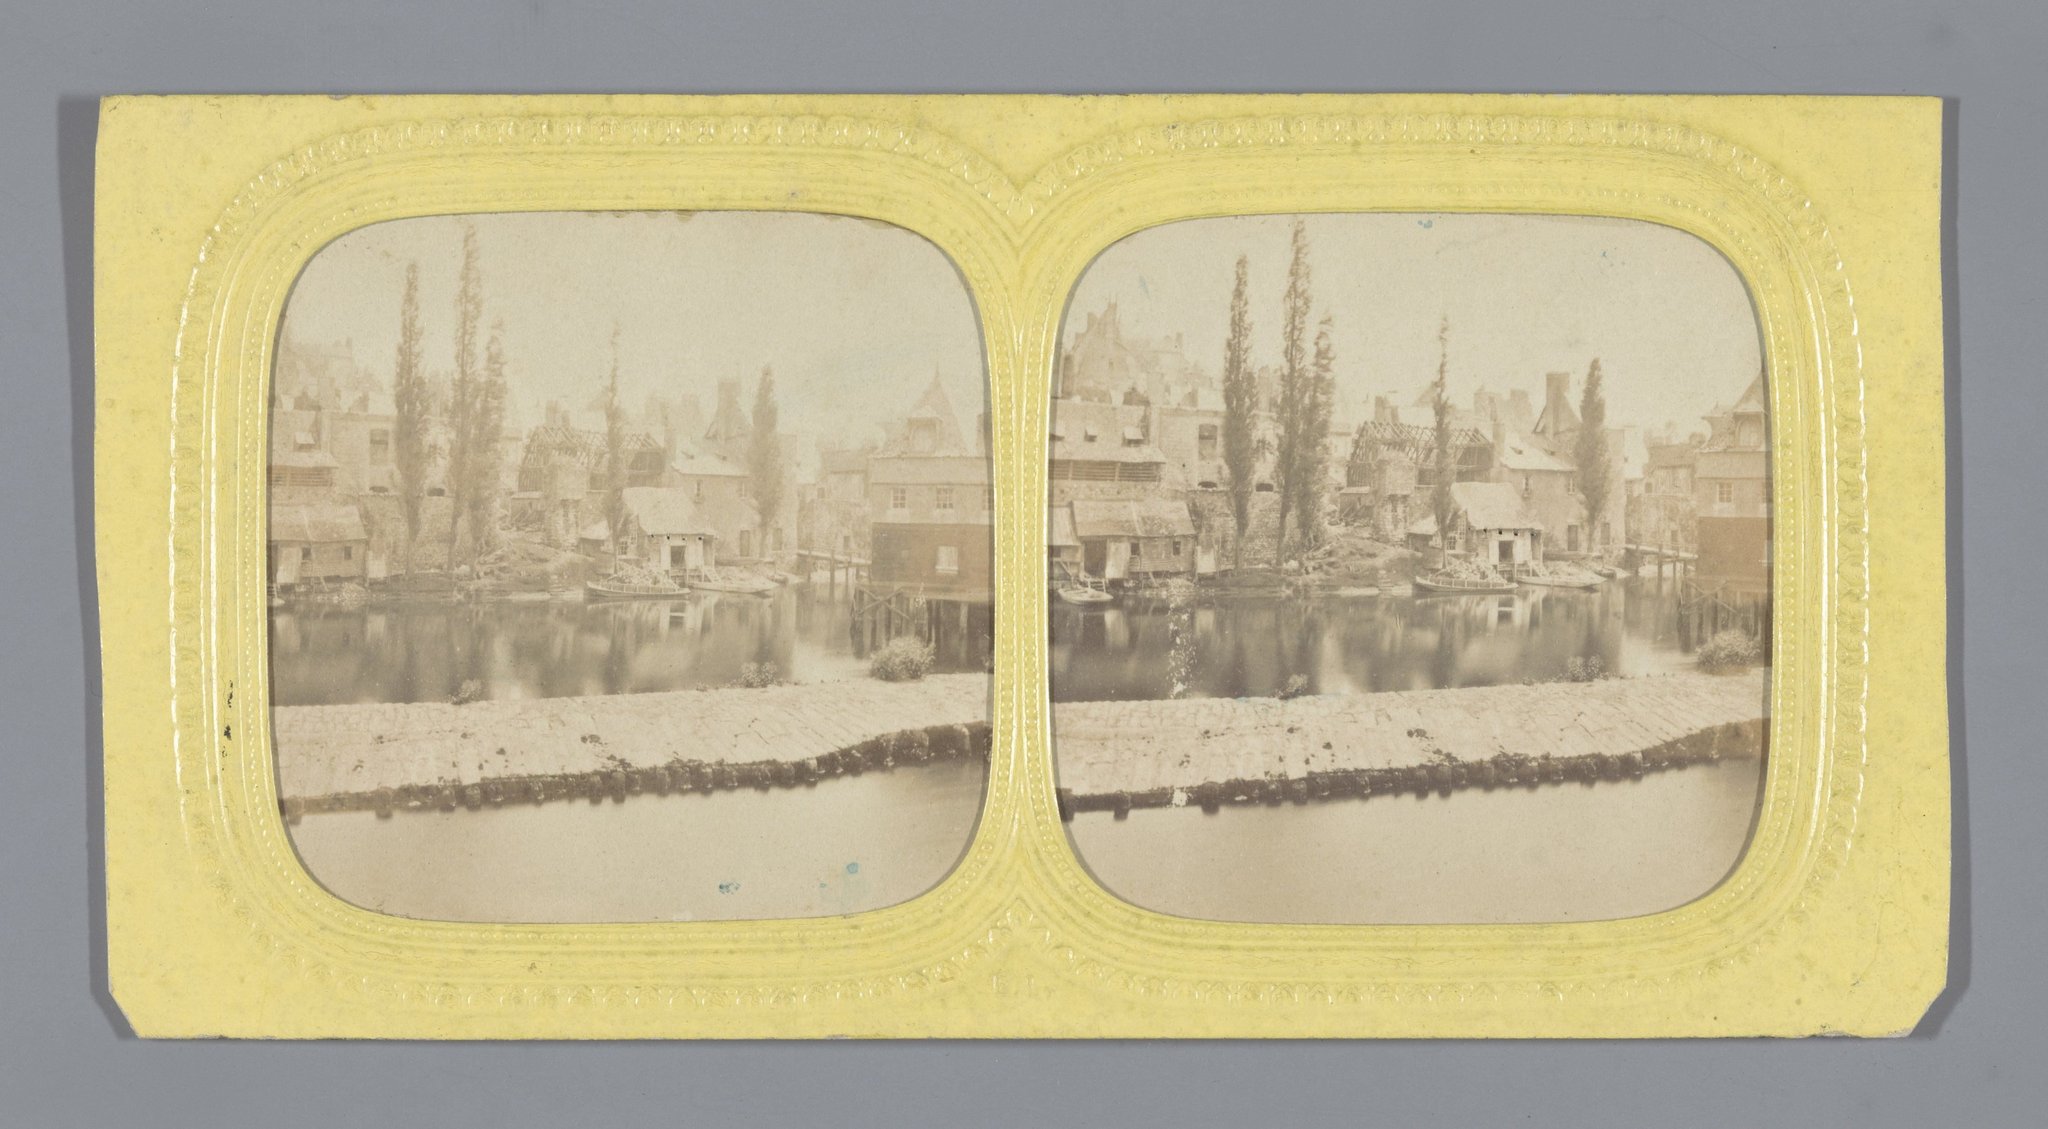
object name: tissue stereograph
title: Le Mans, Sarthe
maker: Anonymous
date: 1855-1875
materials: cardboard, paper, photographic support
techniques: albumen print, hand coloring, perforating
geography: le mans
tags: city-view in general; 'veduta', canals, waters (in city)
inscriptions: monogram: ‘E.L.’